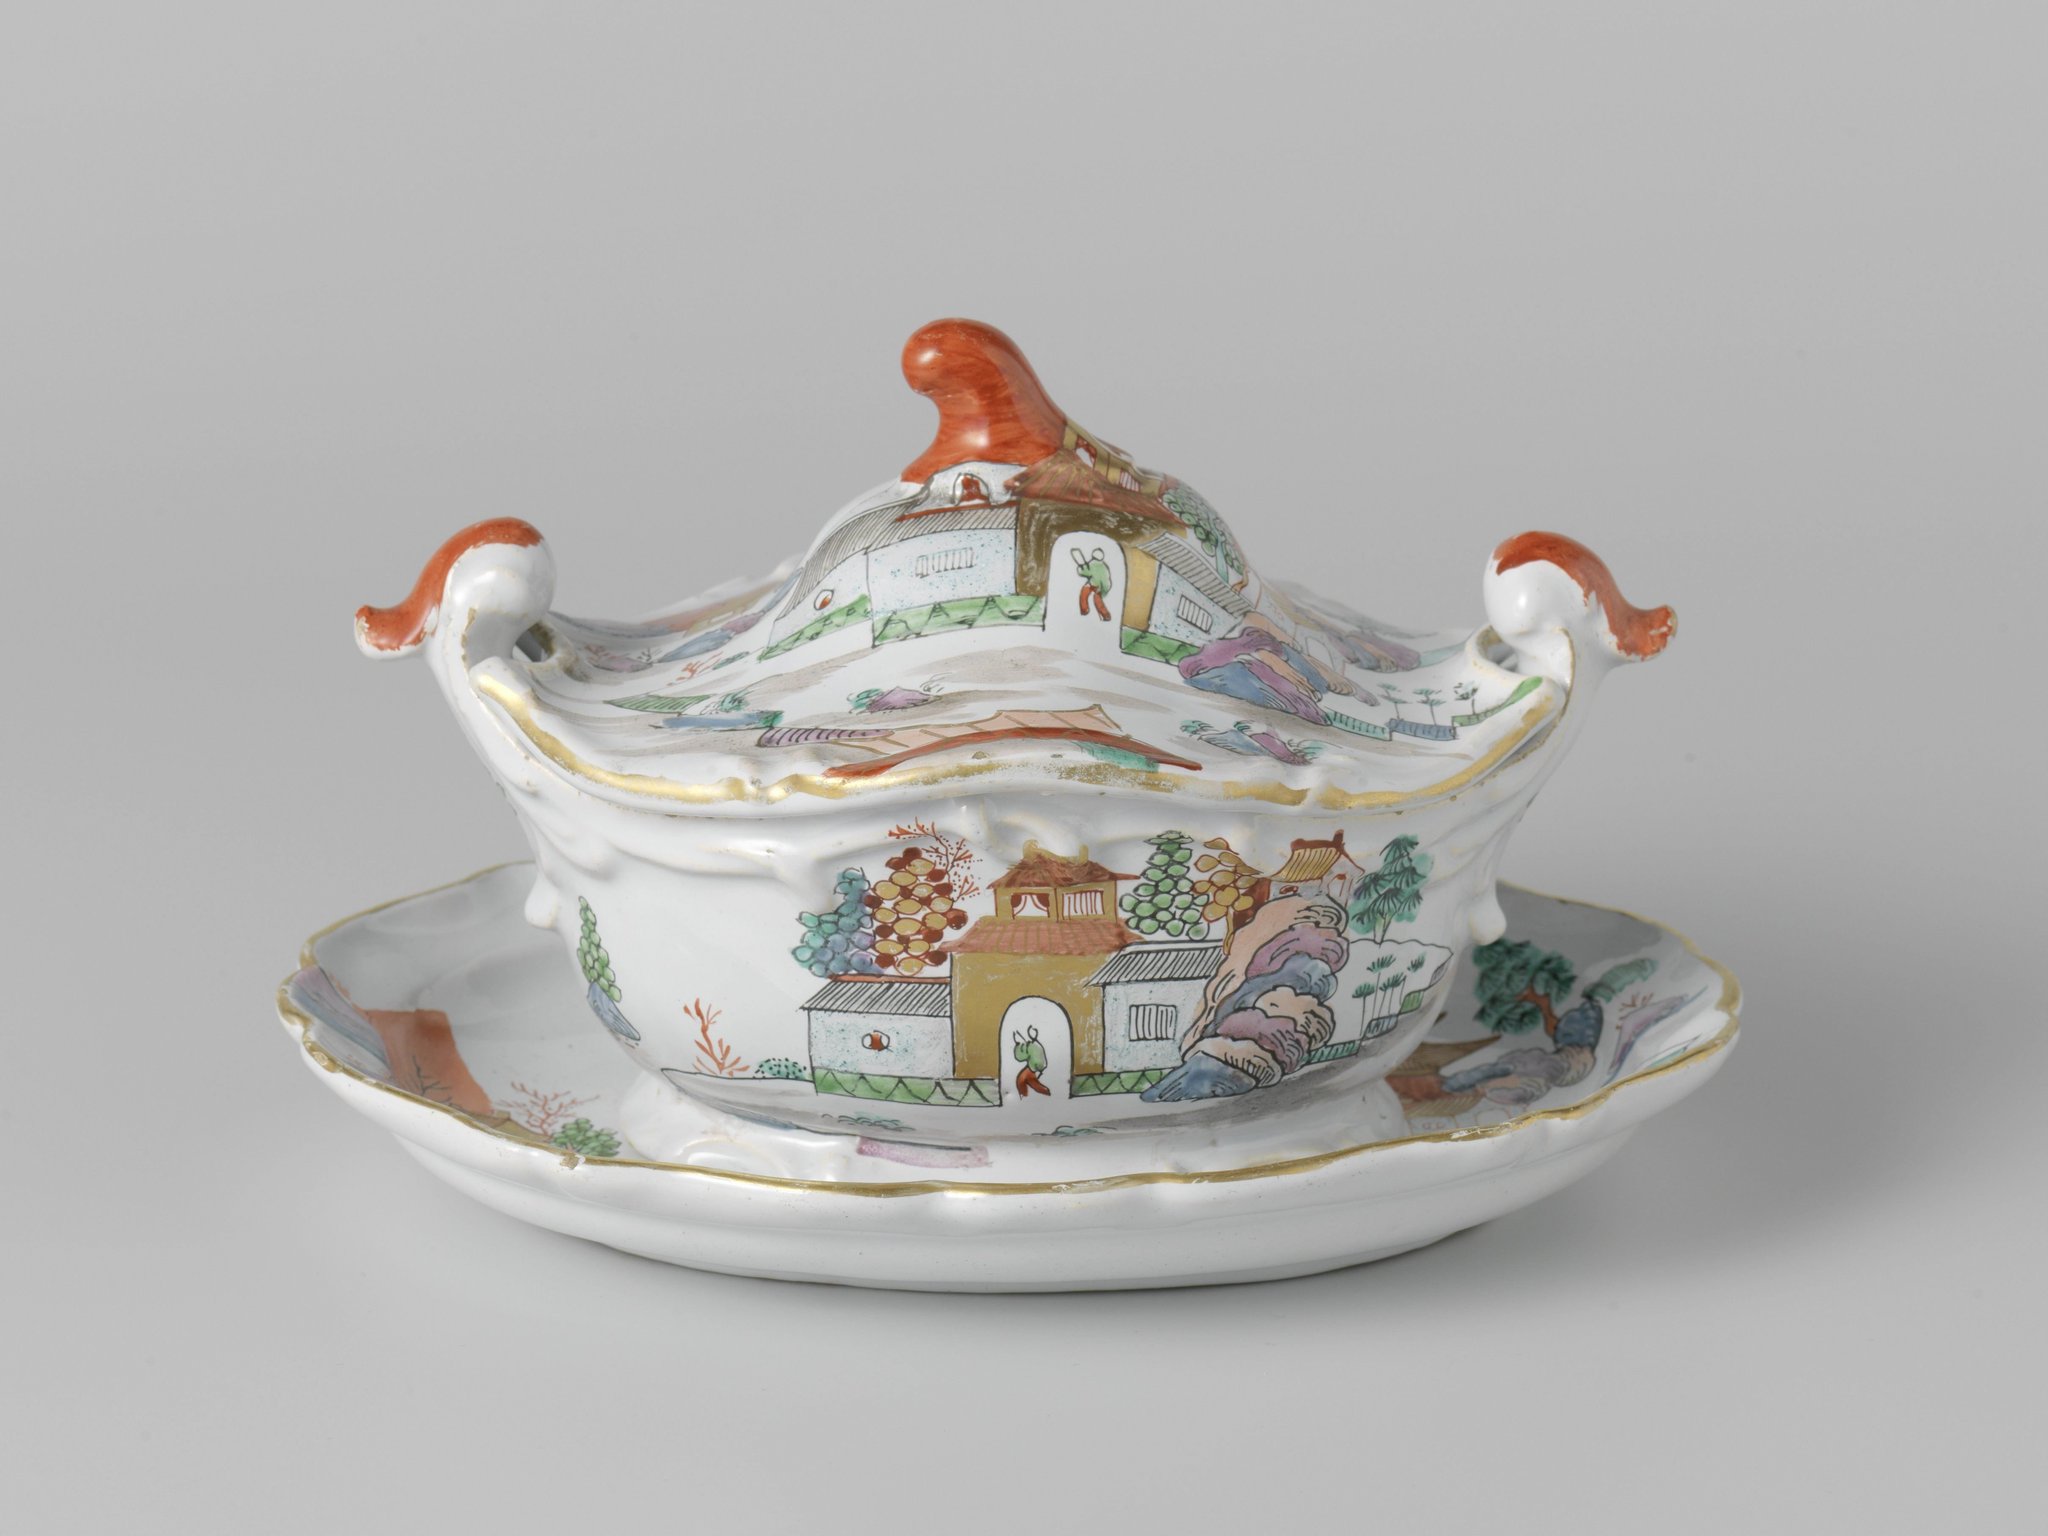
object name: lid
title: Deksel, beschilderd met oosters landschap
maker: jacobus adriaens halder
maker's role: fayencier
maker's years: 1741-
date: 1765-1768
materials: faience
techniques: kiln, painted, polychromy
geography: delft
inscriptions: mark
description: Deksel van botervloot. Met bijbehorende onderschotel (A). Veelkleurig versierd met een oosters landschap met rotsen en gebouwen. Gemerkt in zwart A/IH.